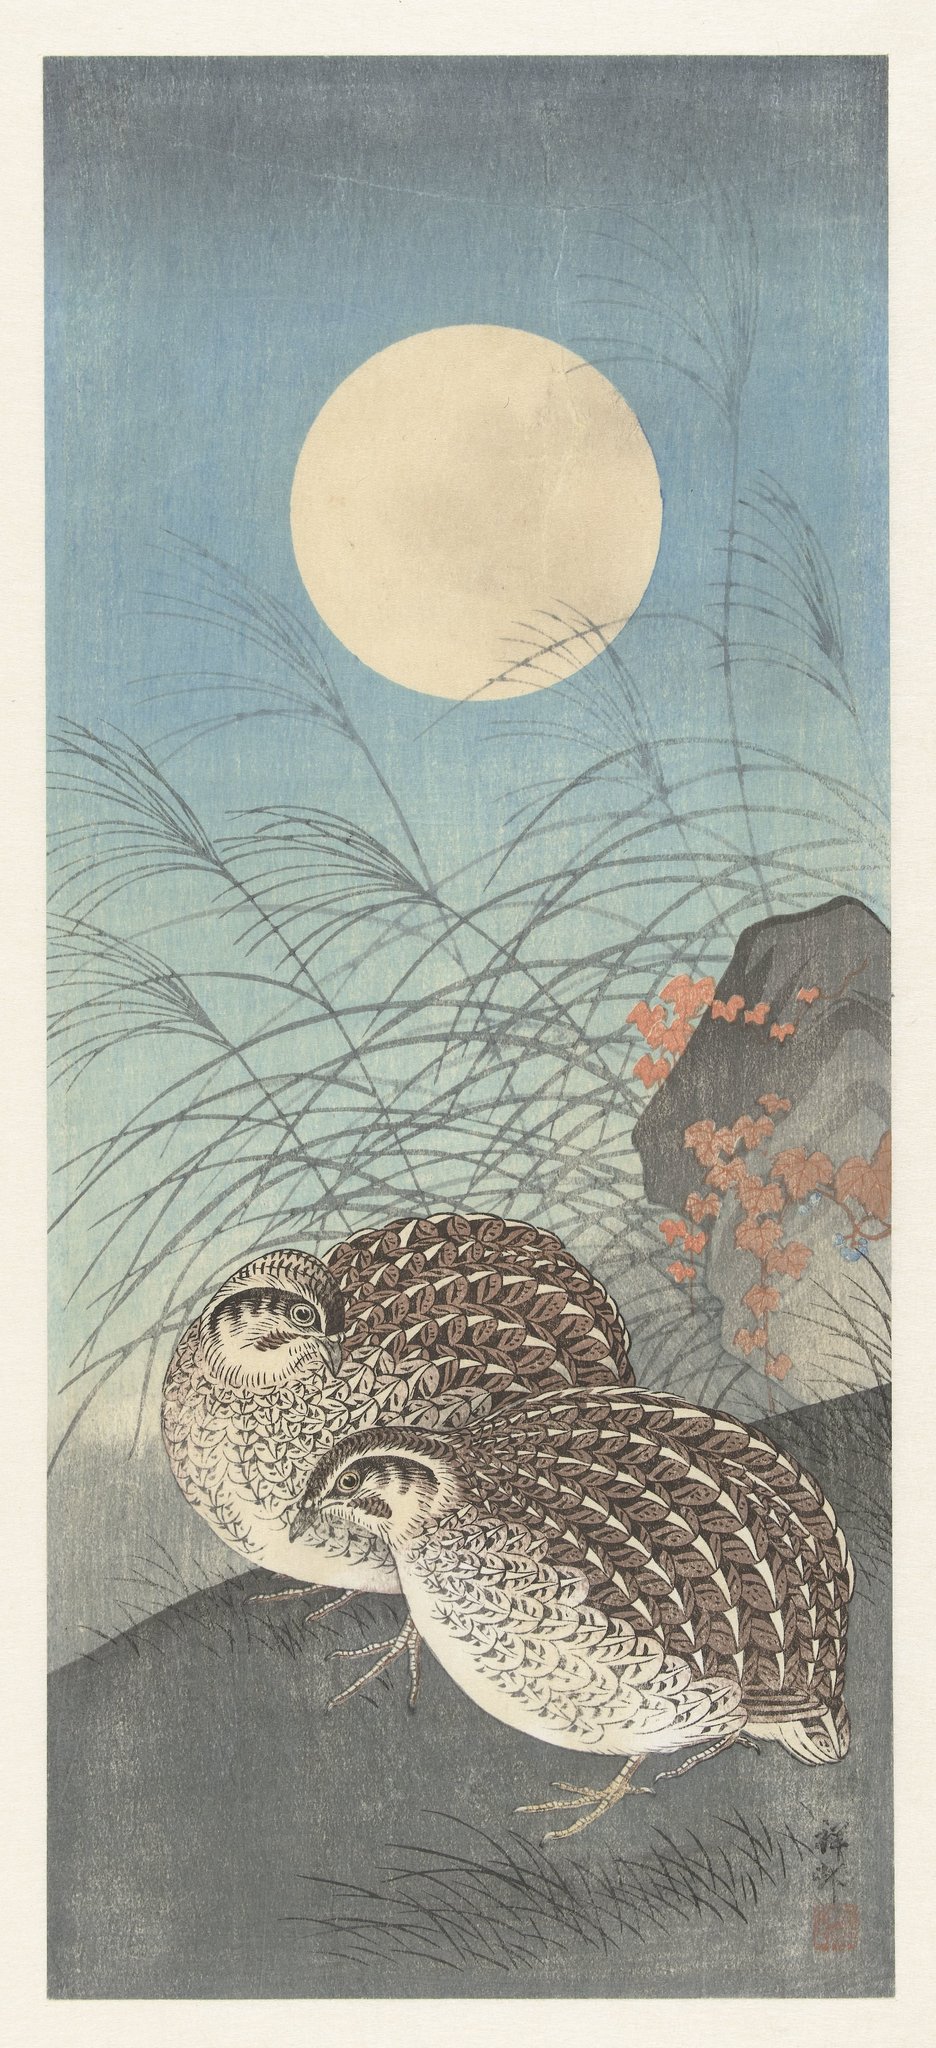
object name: print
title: Twee kwartels bij volle maan.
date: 1900-1936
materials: paper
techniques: woodcut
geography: japan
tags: walker and runner birds (with name)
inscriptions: collector's mark: Lugt 2228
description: Twee kwartels tussen gras, bij volle maan tegen blauwe achtergrond.